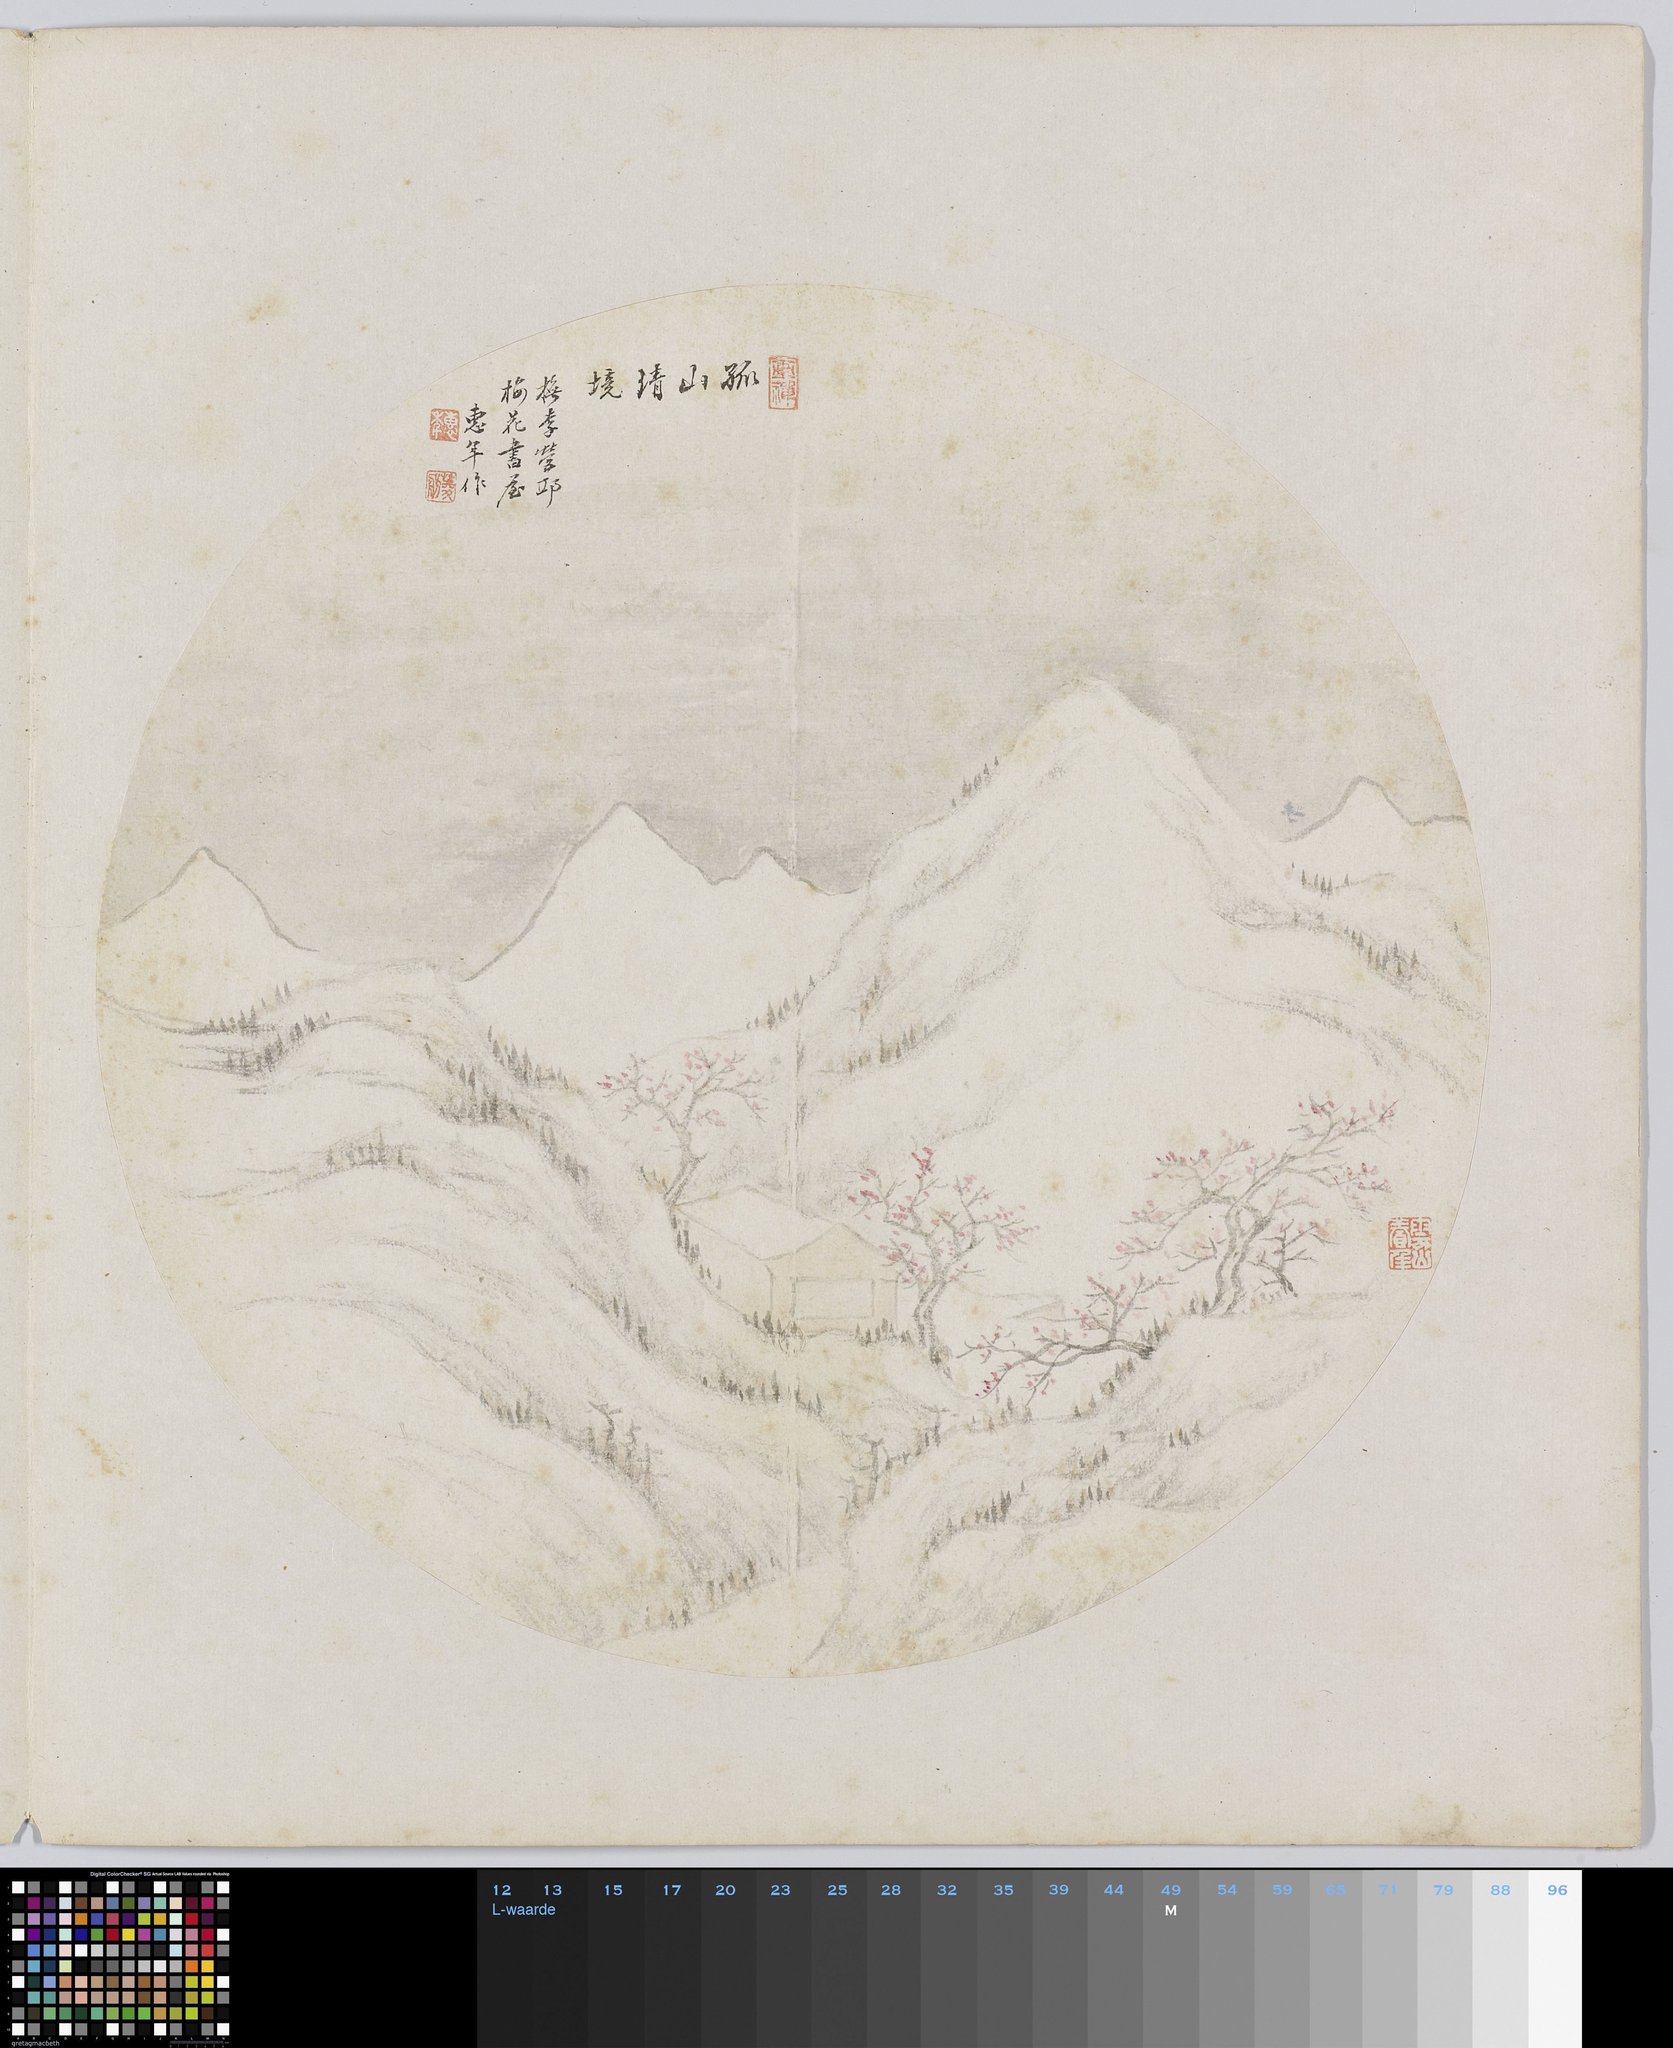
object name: album leaf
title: Albumblad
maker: hui nian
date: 1850-1900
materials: ink, paper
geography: china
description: Albumblad met een landschap. Behoort twee albums met 24 landschappen in de stijl van diverse meesters.